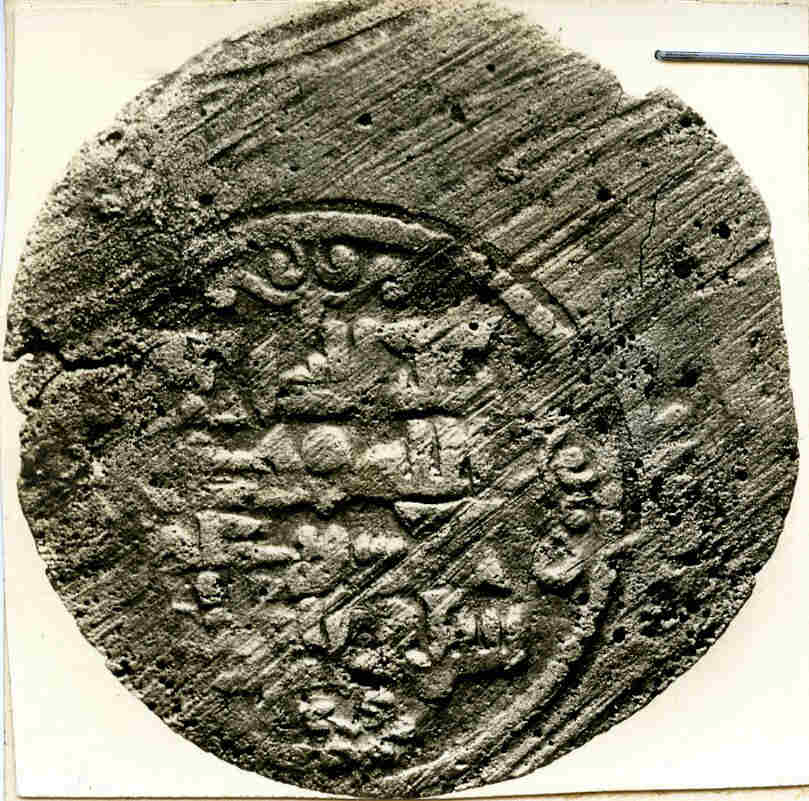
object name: coin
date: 951-1022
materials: copper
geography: iran